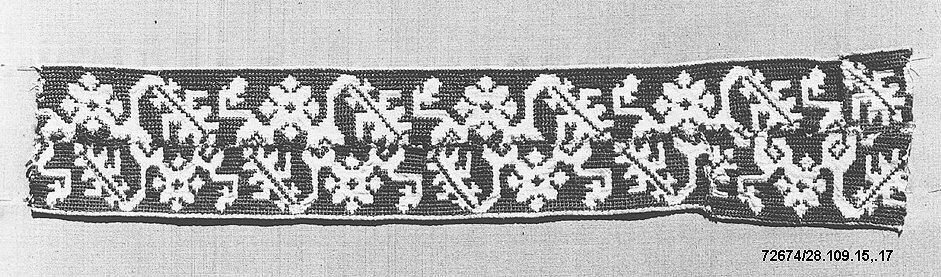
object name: fragment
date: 1601-1700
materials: cotton, silk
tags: flowers